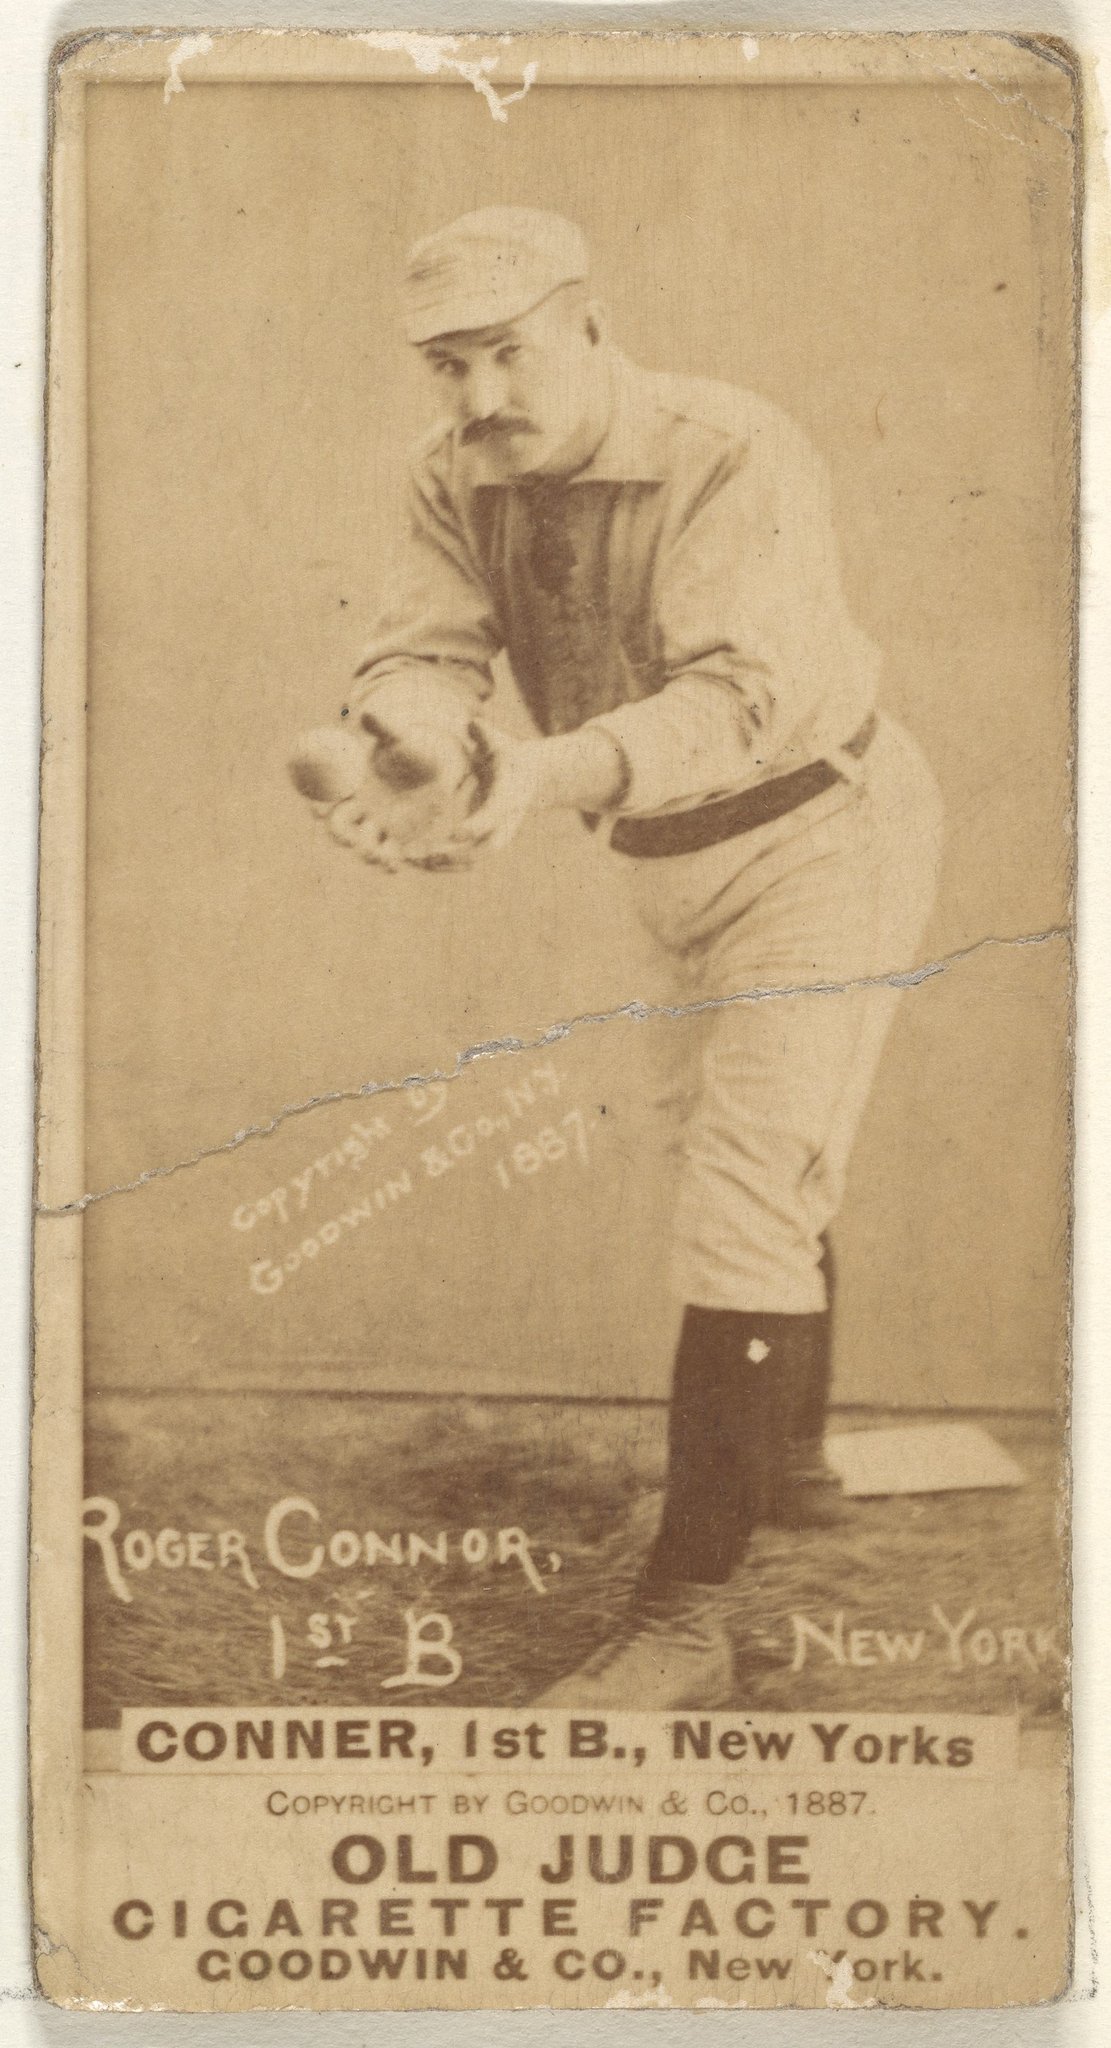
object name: baseball card, photograph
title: Roger Connor, 1st Base, New York, from the Old Judge series (N172) for Old Judge Cigarettes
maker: goodwin & company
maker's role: publisher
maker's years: 1850-1950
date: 1887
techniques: albumen silver print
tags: men,portraits,baseball,athletes